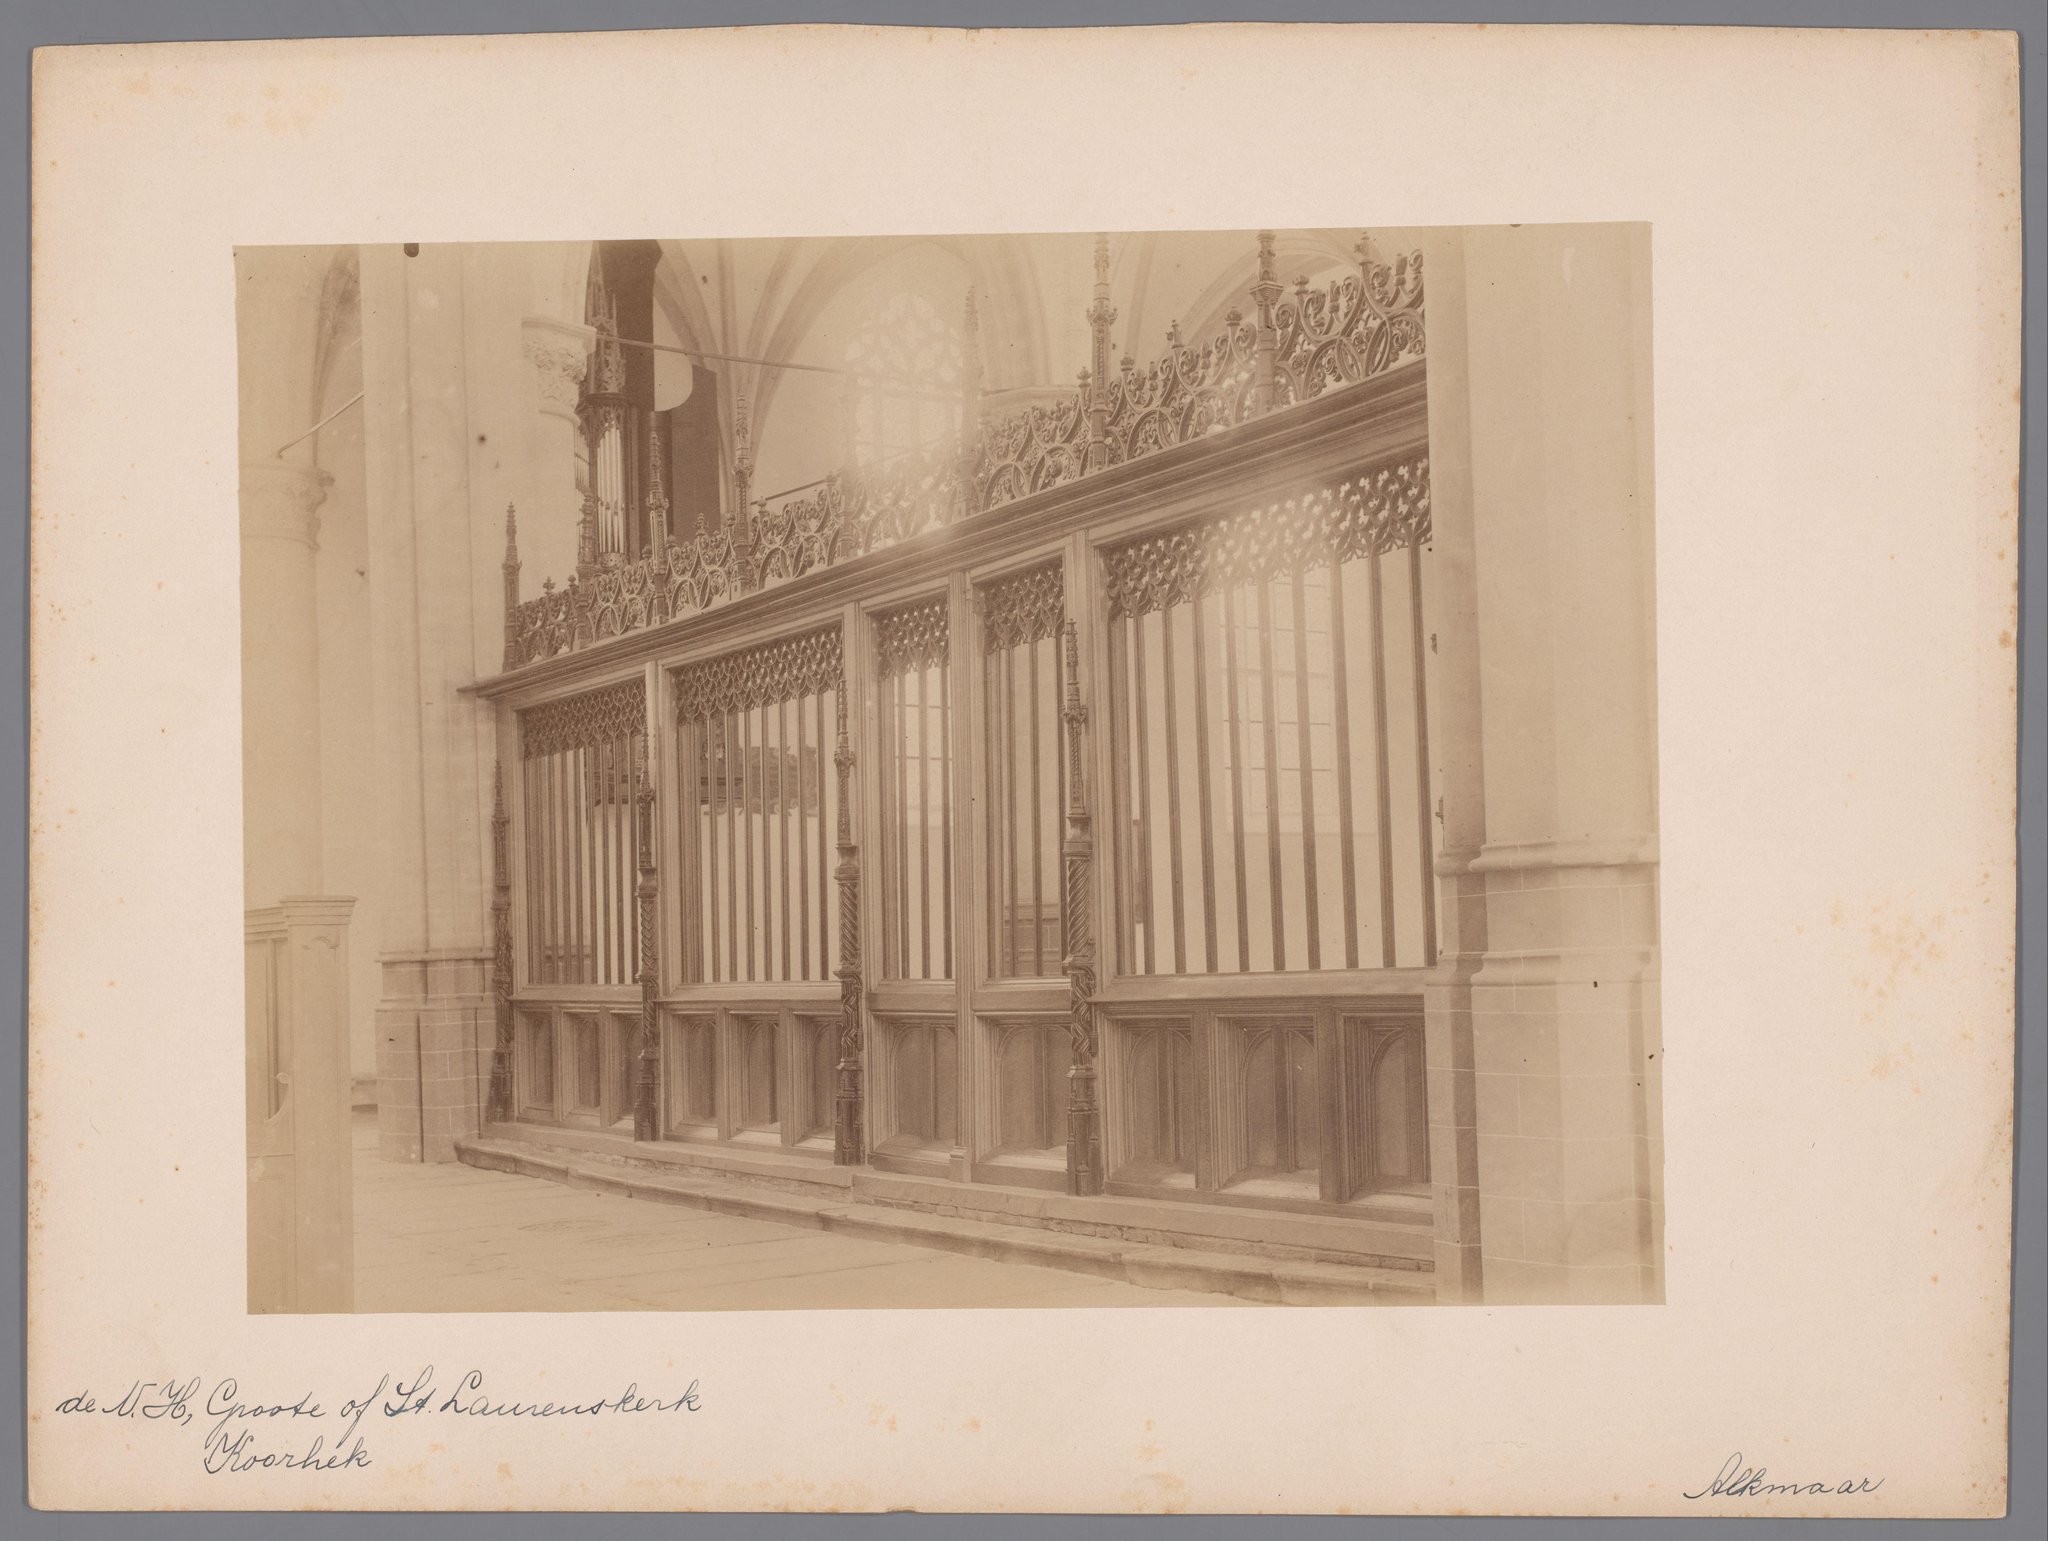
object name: photograph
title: Koorhek in de Grote of Sint-Laurenskerk te Alkmaar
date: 1895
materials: cardboard, photographic support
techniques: albumen print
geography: grote of sint-laurenskerk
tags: parts of church interior: choir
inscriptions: annotation: ‘de N.H, Groote of St. Laurenskerk/ Koorhek/ Alkmaar’, annotation: ‘Alkmaar (N.H.)/ Koorhek in de NH kerk/ Aug 1895’